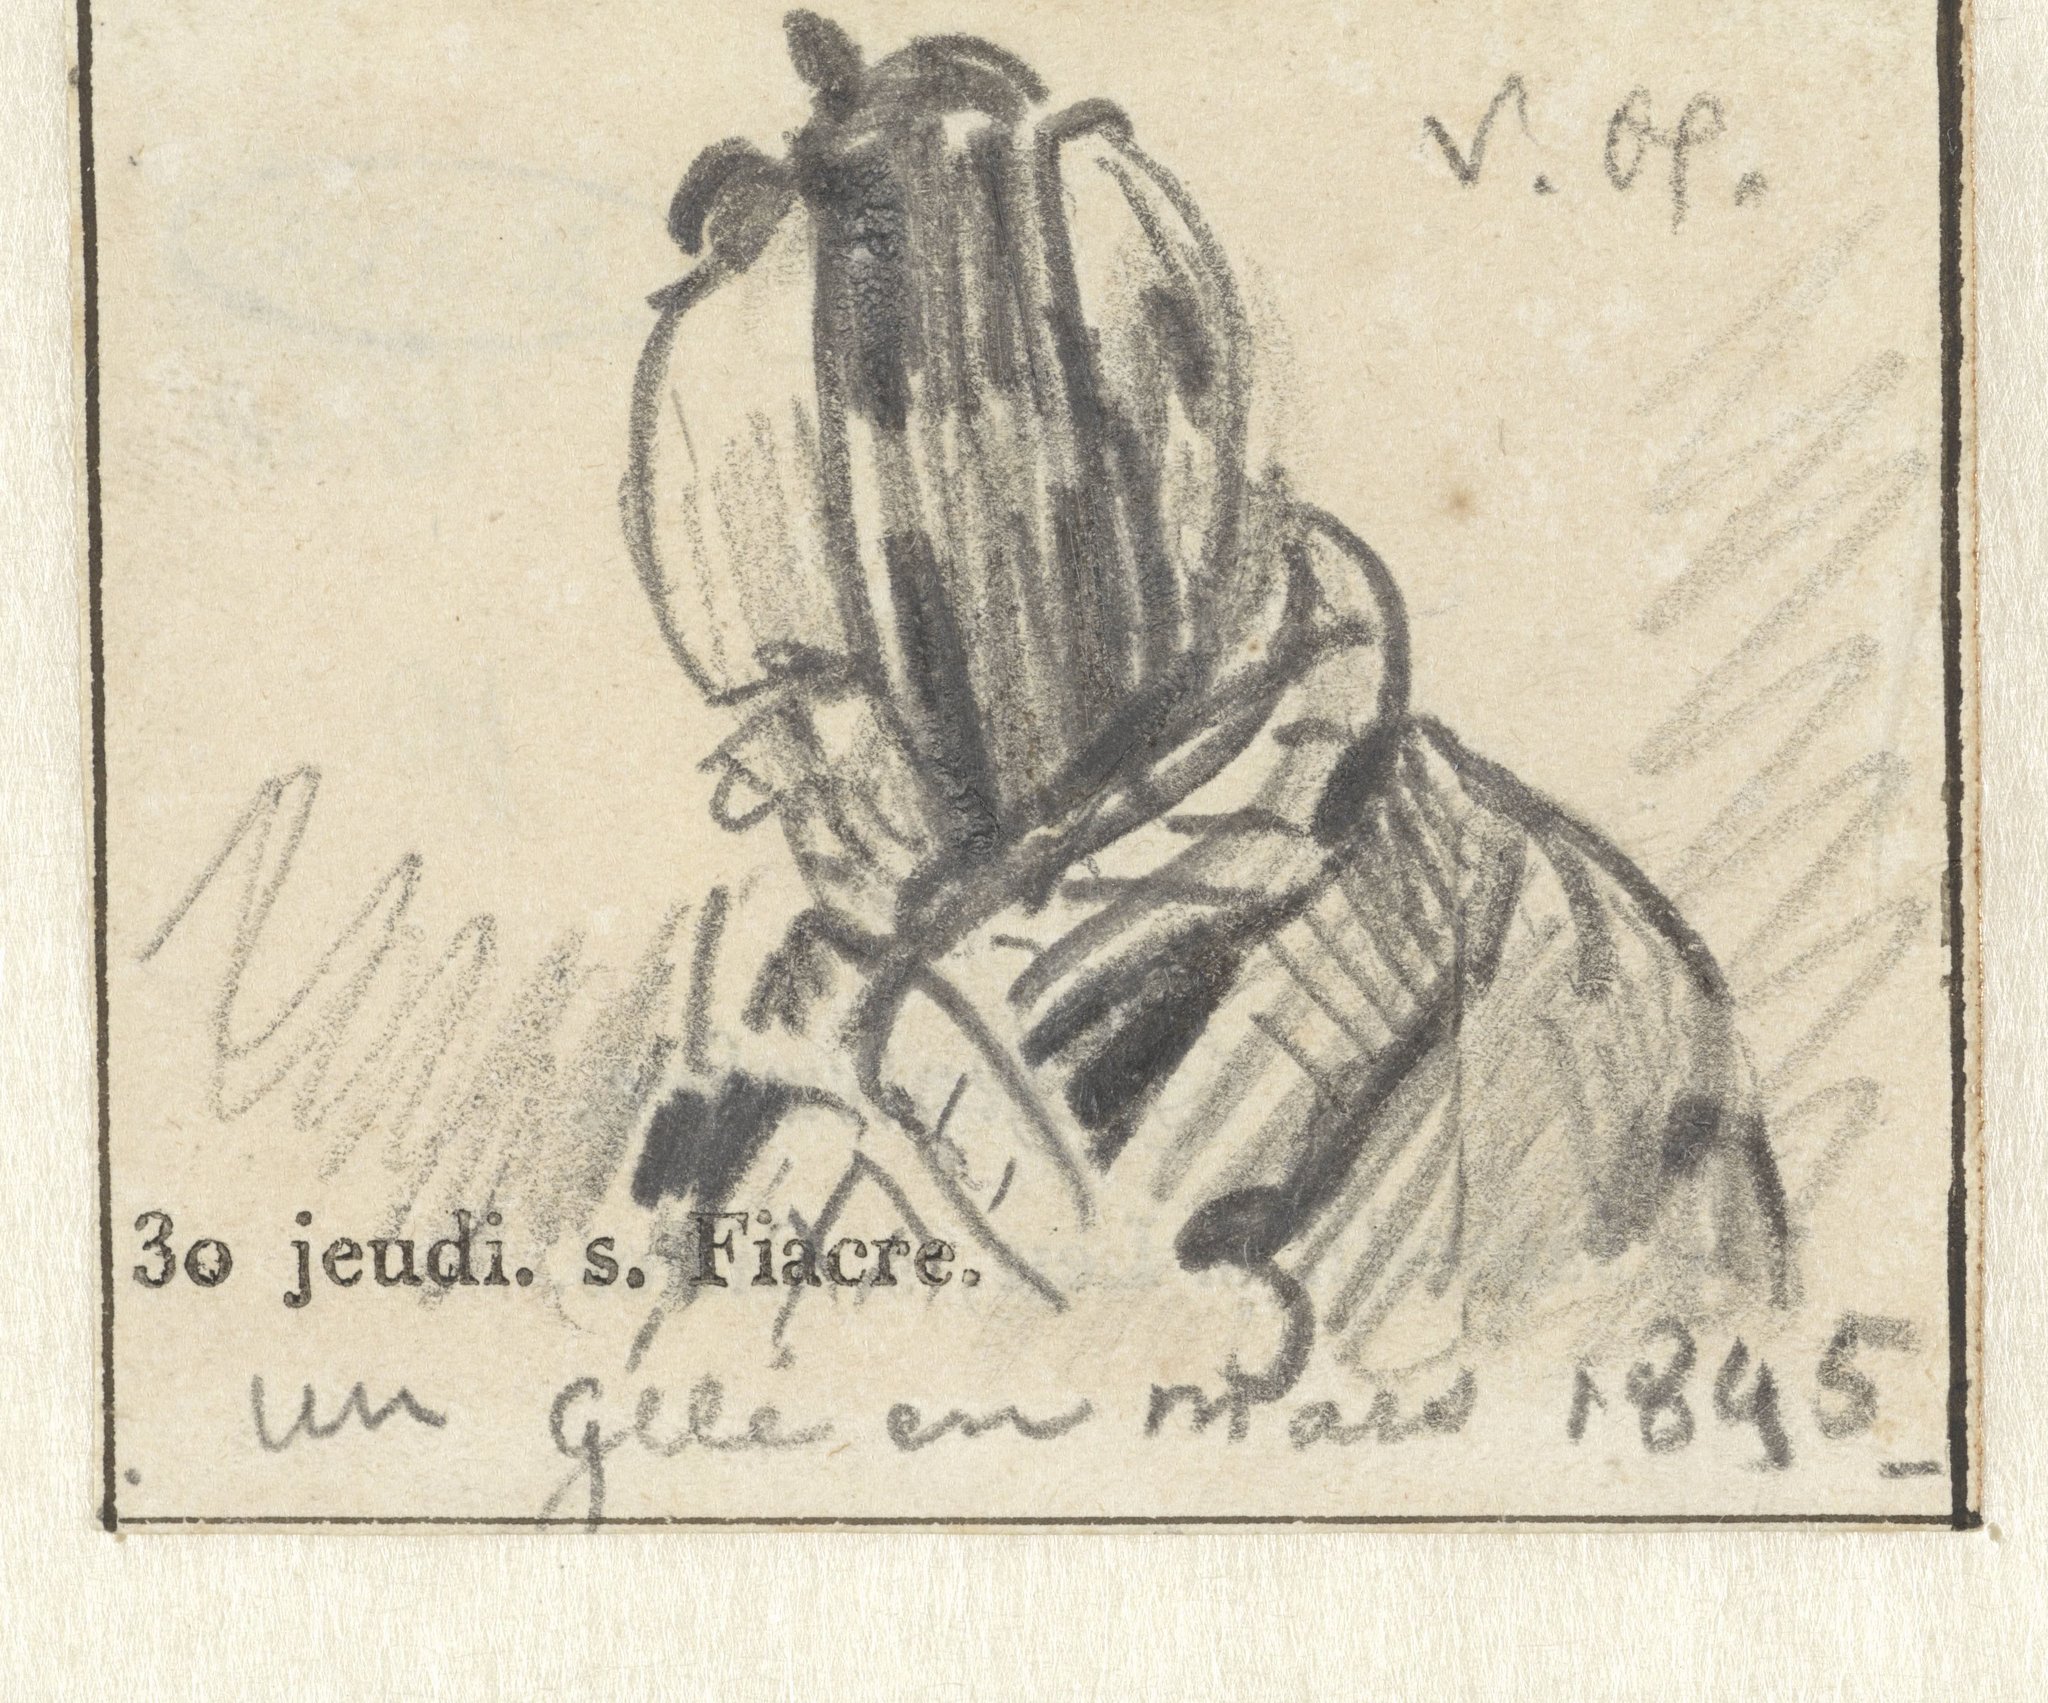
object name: drawing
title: Profiel van een vrouw, naar links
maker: georgius jacobus johannes van os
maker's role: draughtsman, painter, print maker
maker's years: 1782-1861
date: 1845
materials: paper, pencil